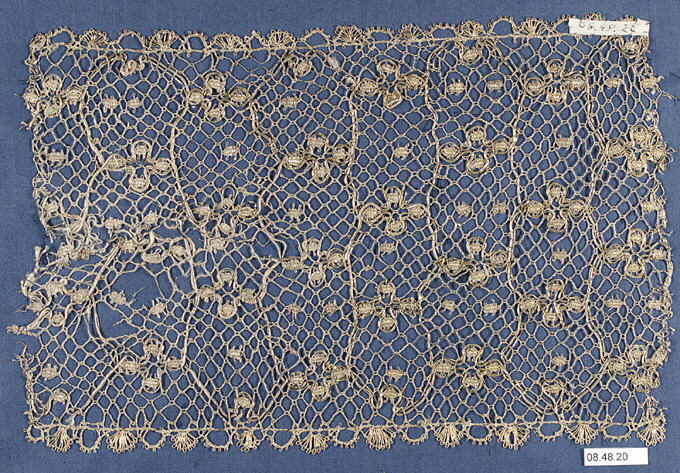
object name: fragment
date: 1701-1800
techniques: lace